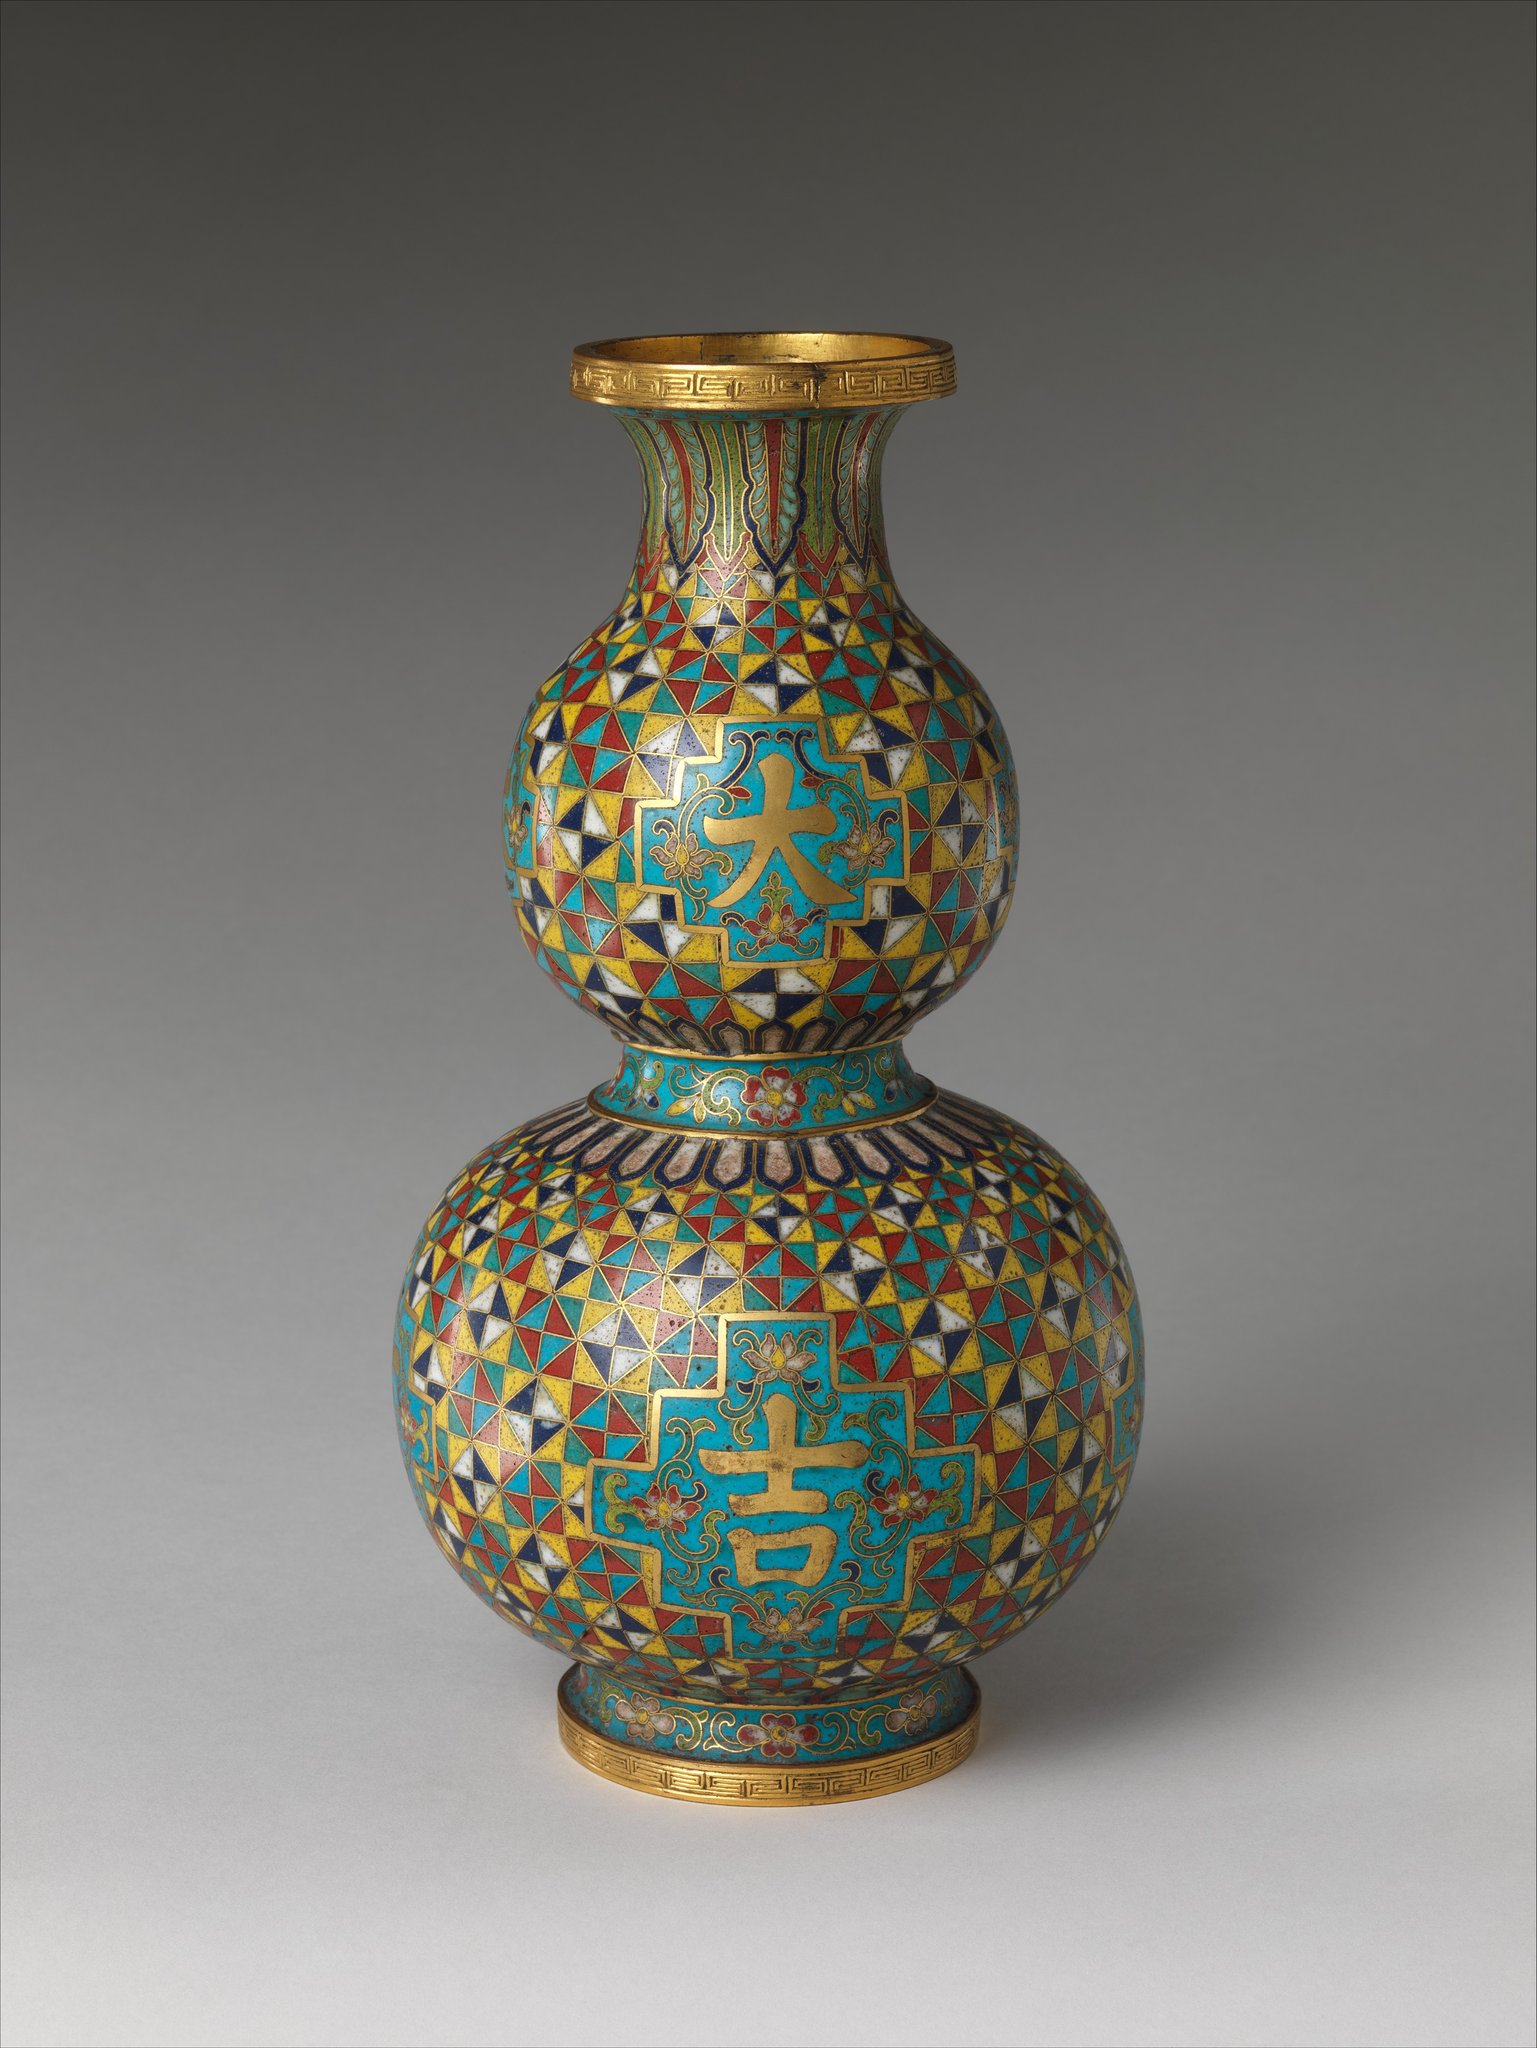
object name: vase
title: Gourd-shaped vase with characters for “grand luck” (da ji)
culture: chinese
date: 1767-1833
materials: enamel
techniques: enamel